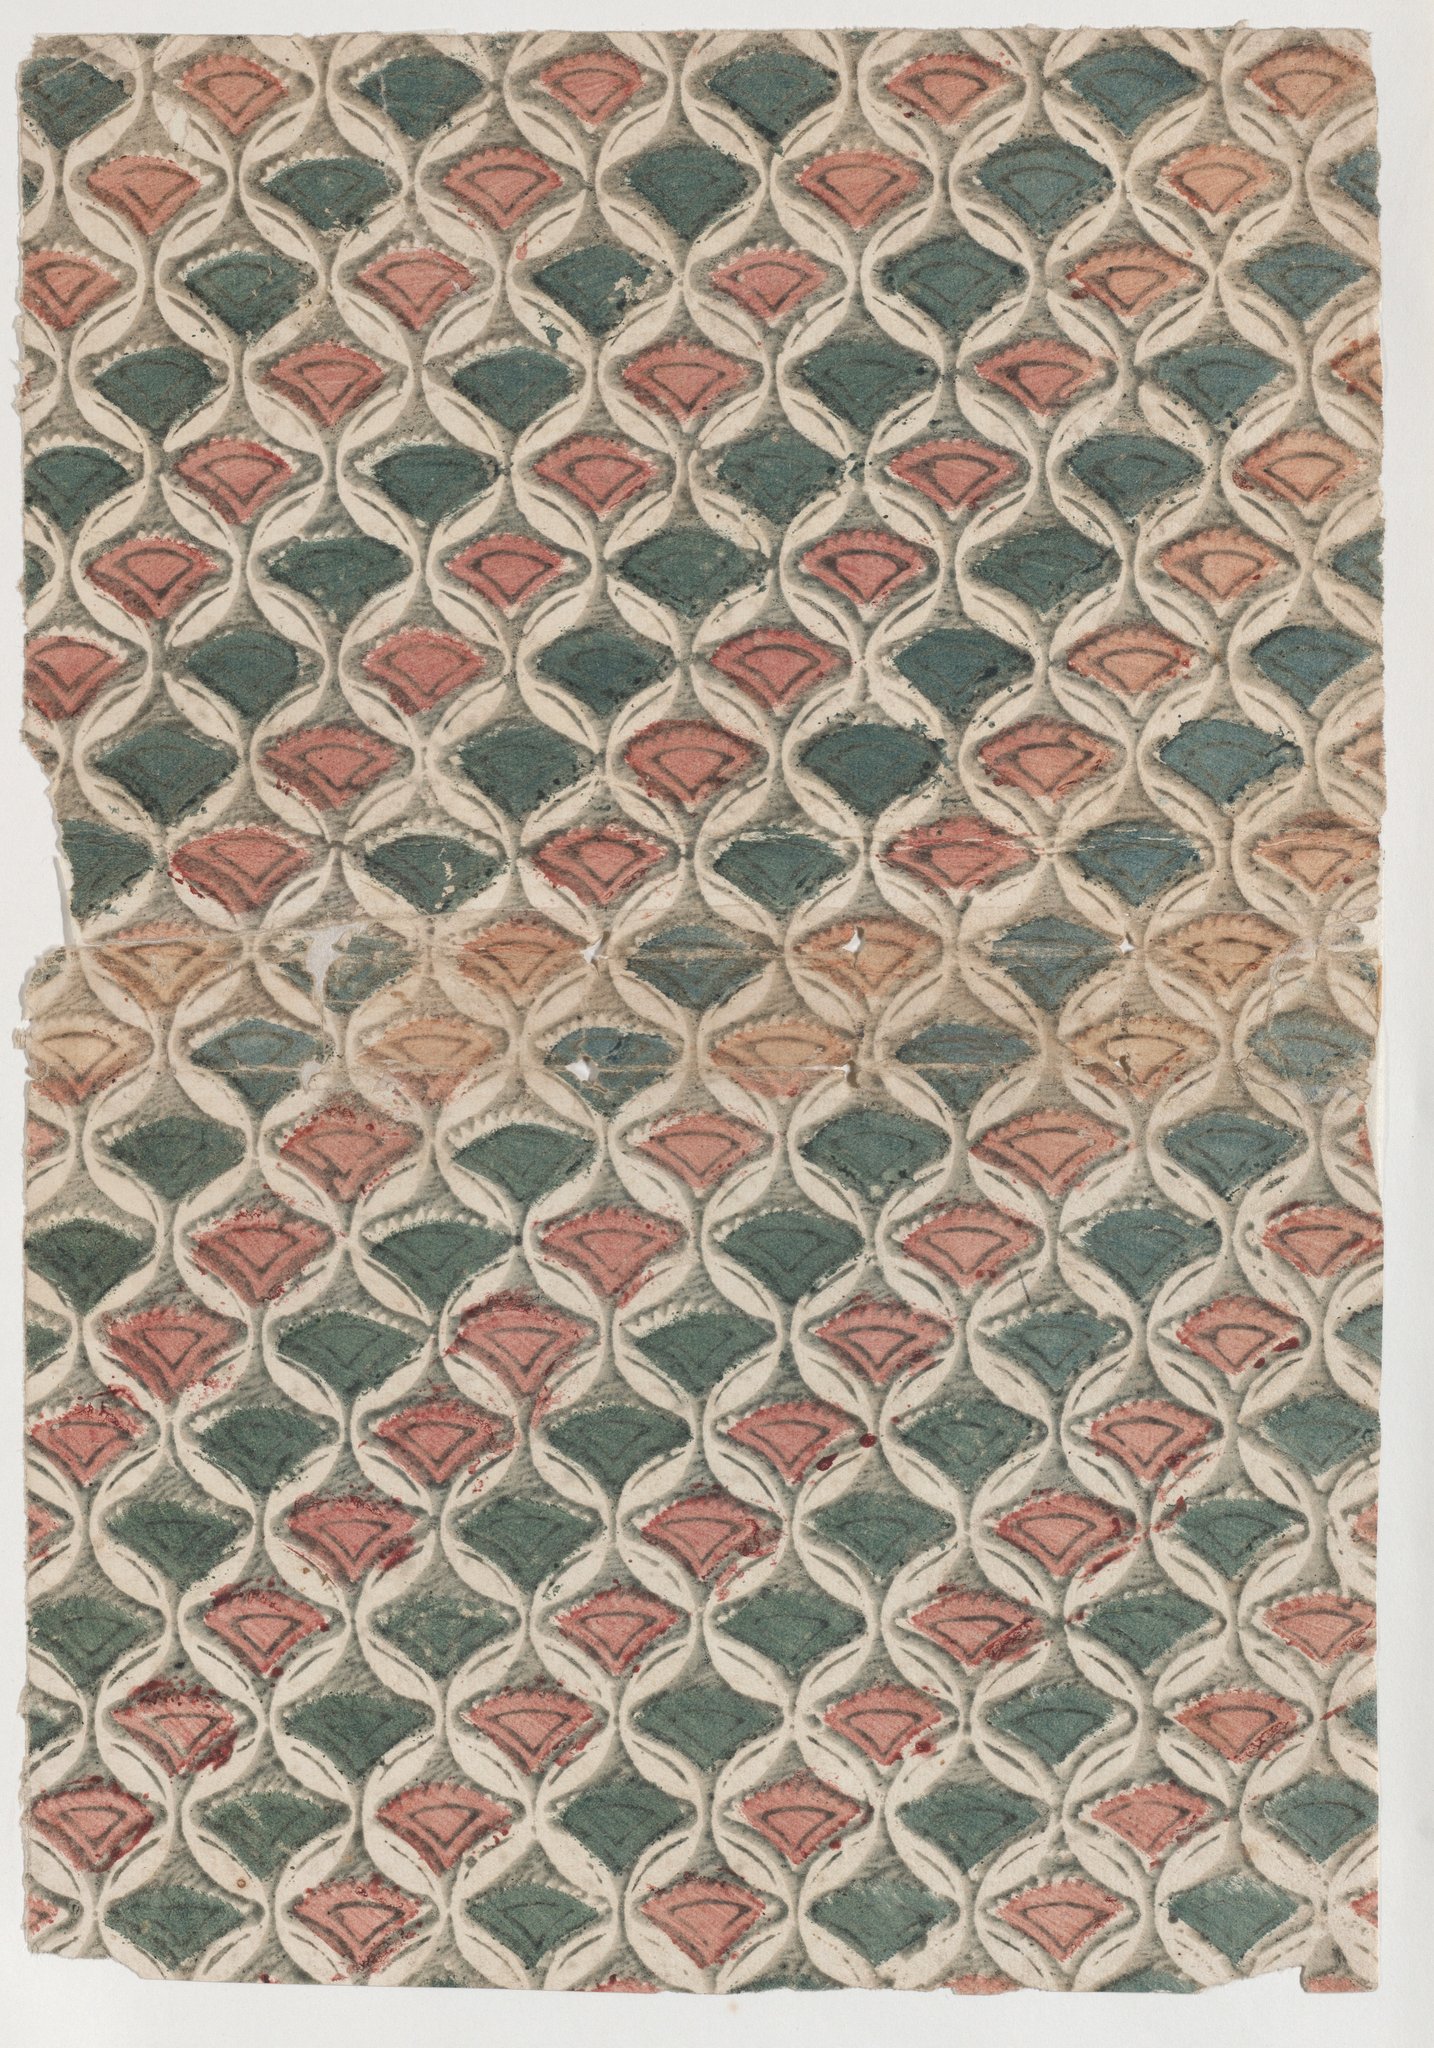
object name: print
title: Book cover with overall circular design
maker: Anonymous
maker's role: artist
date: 1801-1900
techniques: relief print